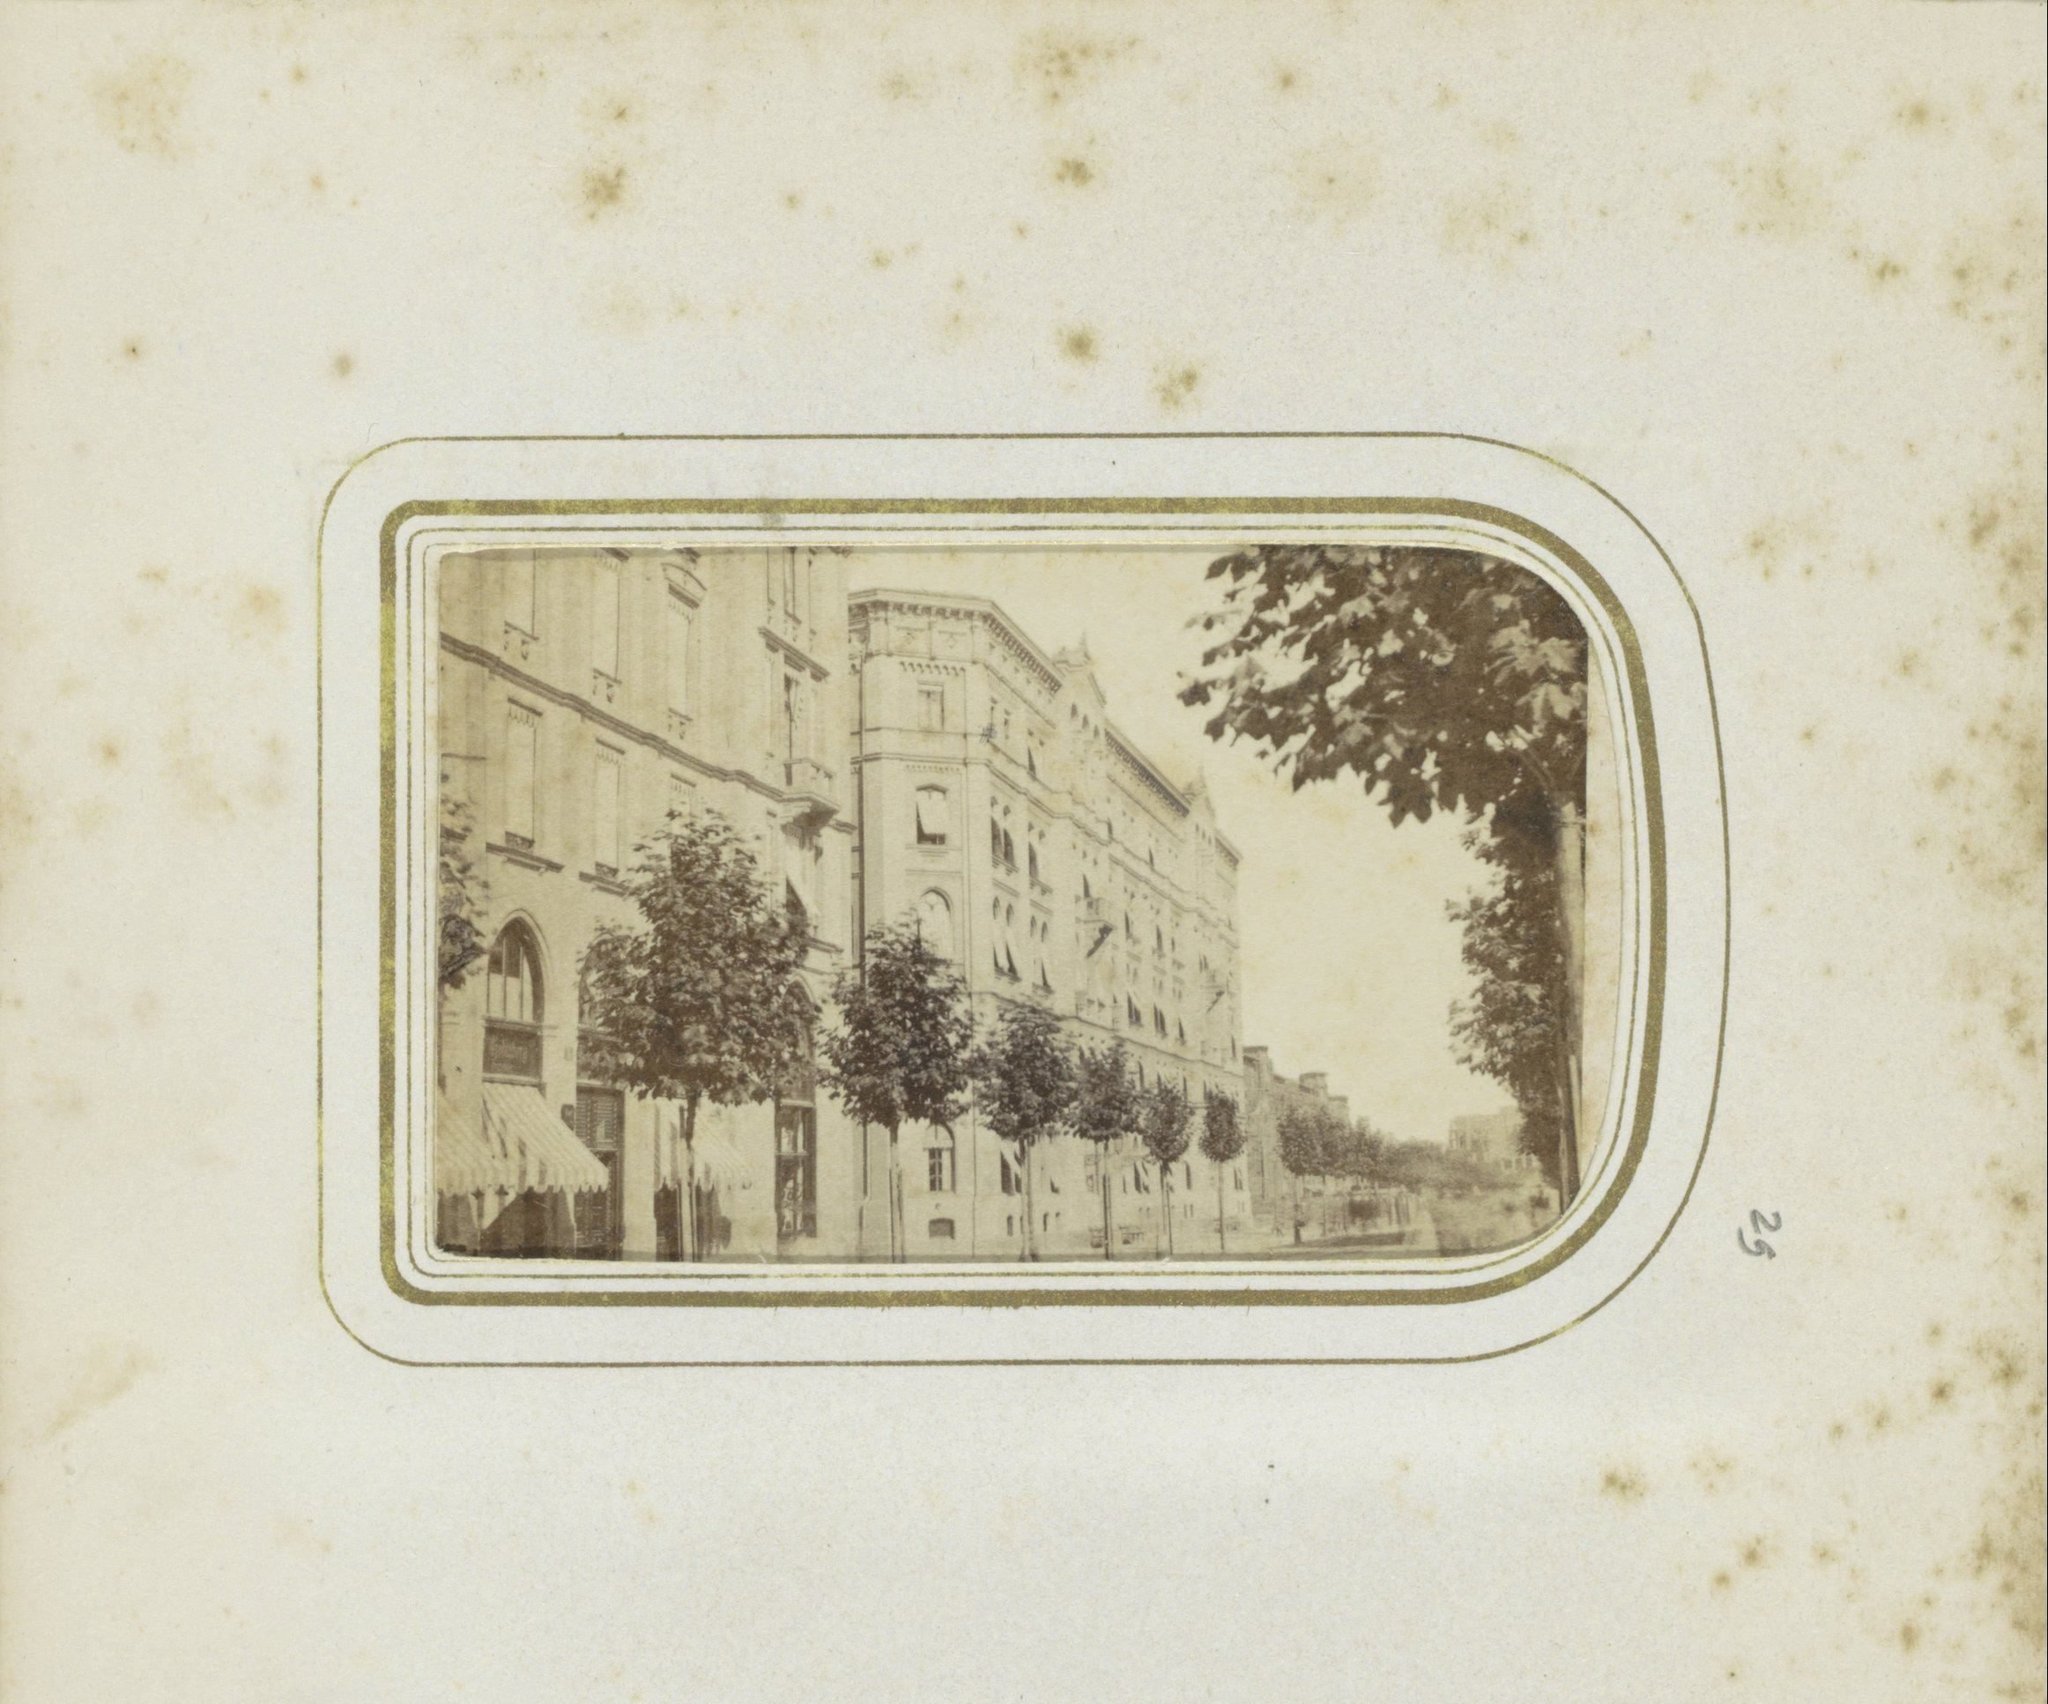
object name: photograph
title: Exterieur van Hotel vier Jahreszeiten in München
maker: Anonymous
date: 1865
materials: paper, photographic support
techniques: albumen print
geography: munich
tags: trees, travelling; tourism, hotel, hostelry, inn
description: Onderdeel van Fotoalbum van een reis door Zwitserland, Oostenrijk en Duitsland door de Nederlandse familie Derkinderen.